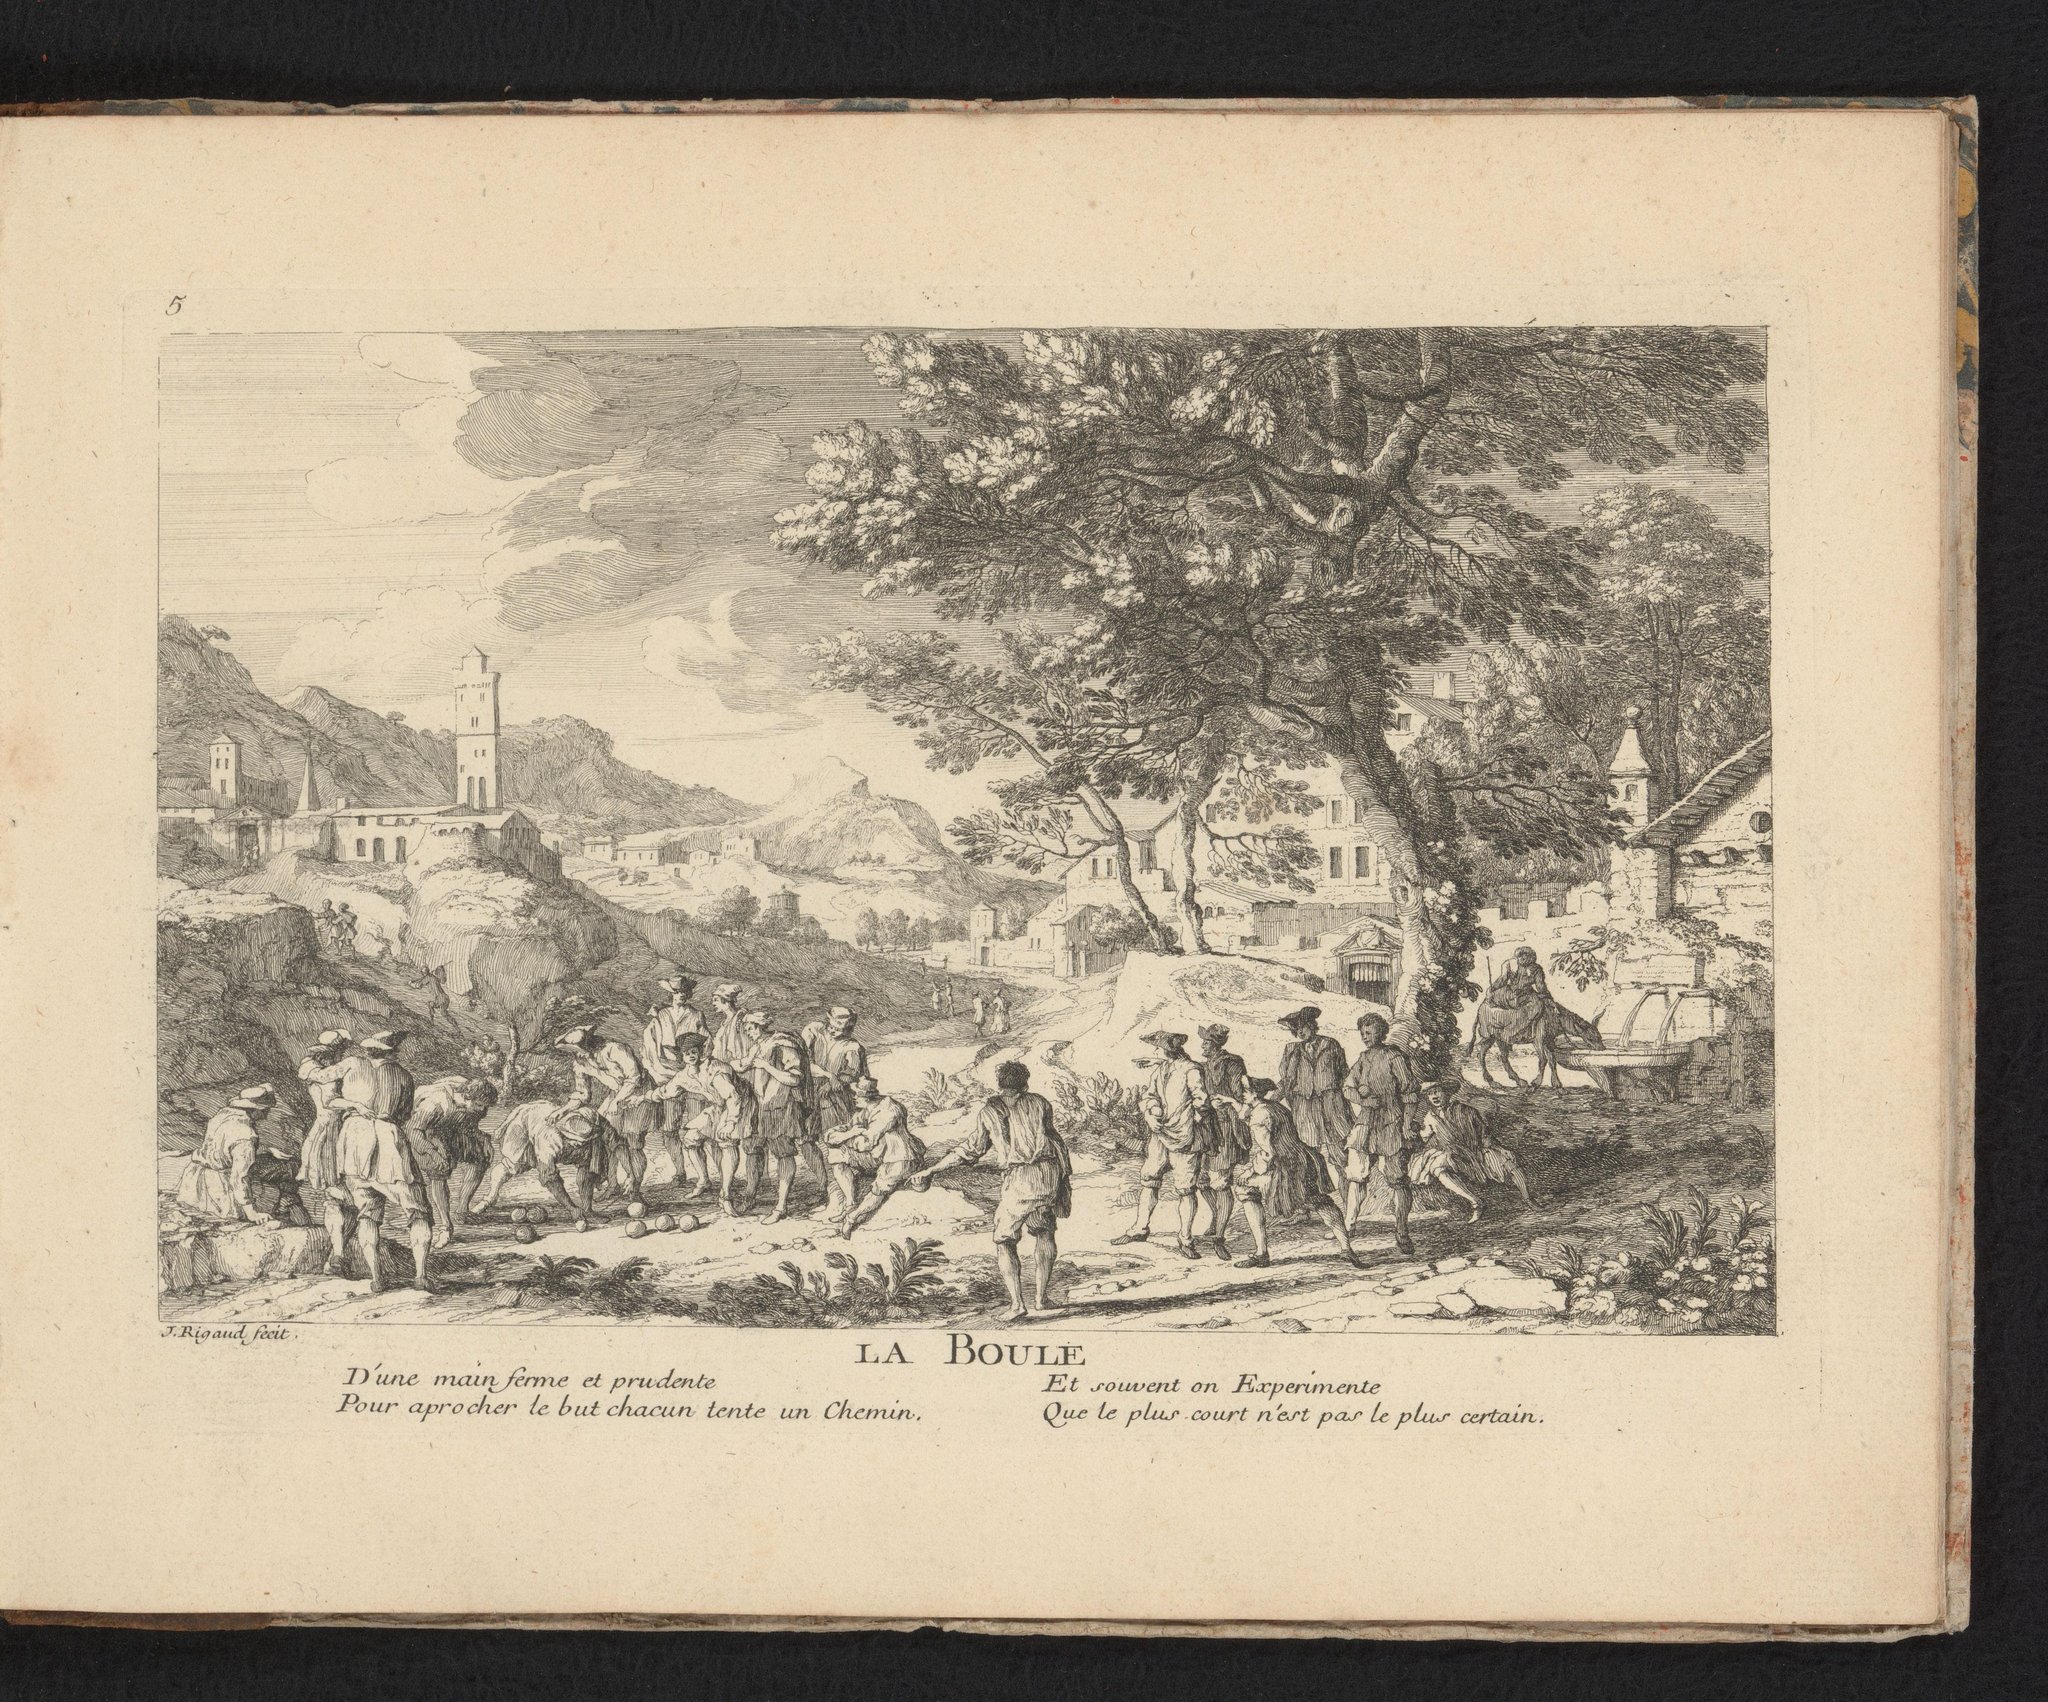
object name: album leaf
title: Provence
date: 1700-1725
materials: paper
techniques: etching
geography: paris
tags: ass, donkey, village, 'jeu de boules'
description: Deze prent maakt deel uit van een album.